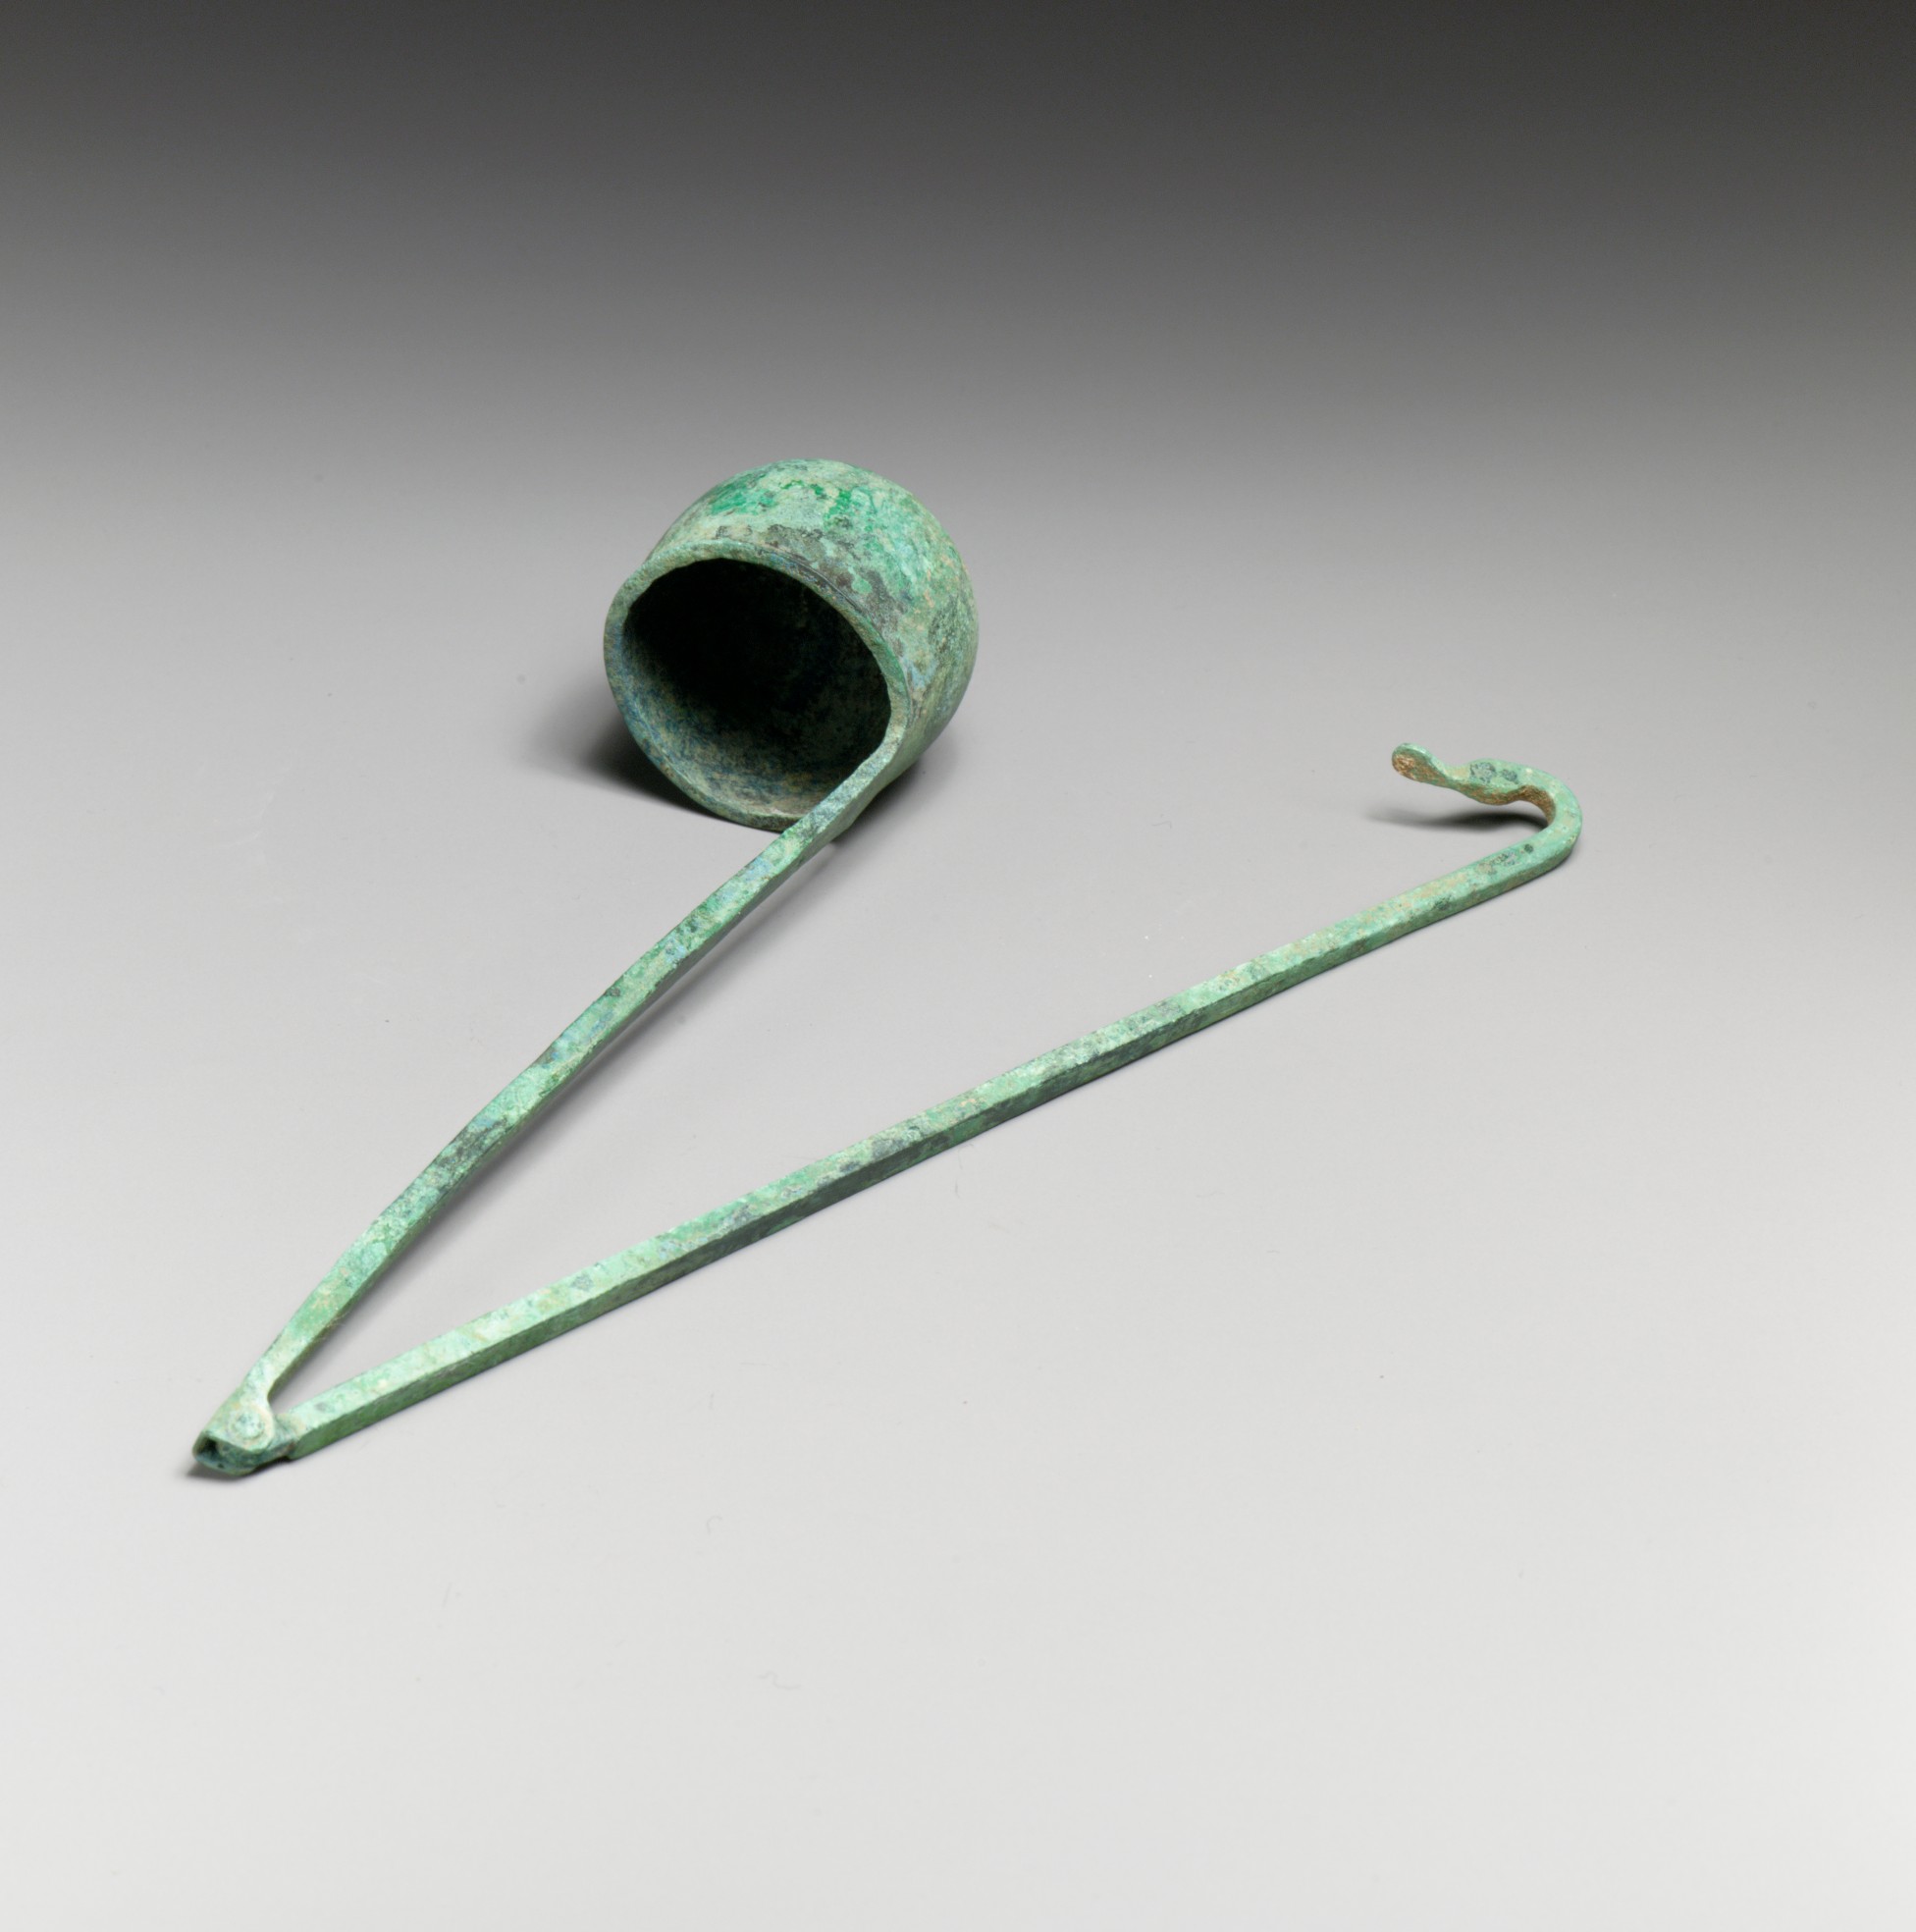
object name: kyathos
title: Bronze kyathos (ladle) terminating in a duck's head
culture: roman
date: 101-200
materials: bronze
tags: ducks